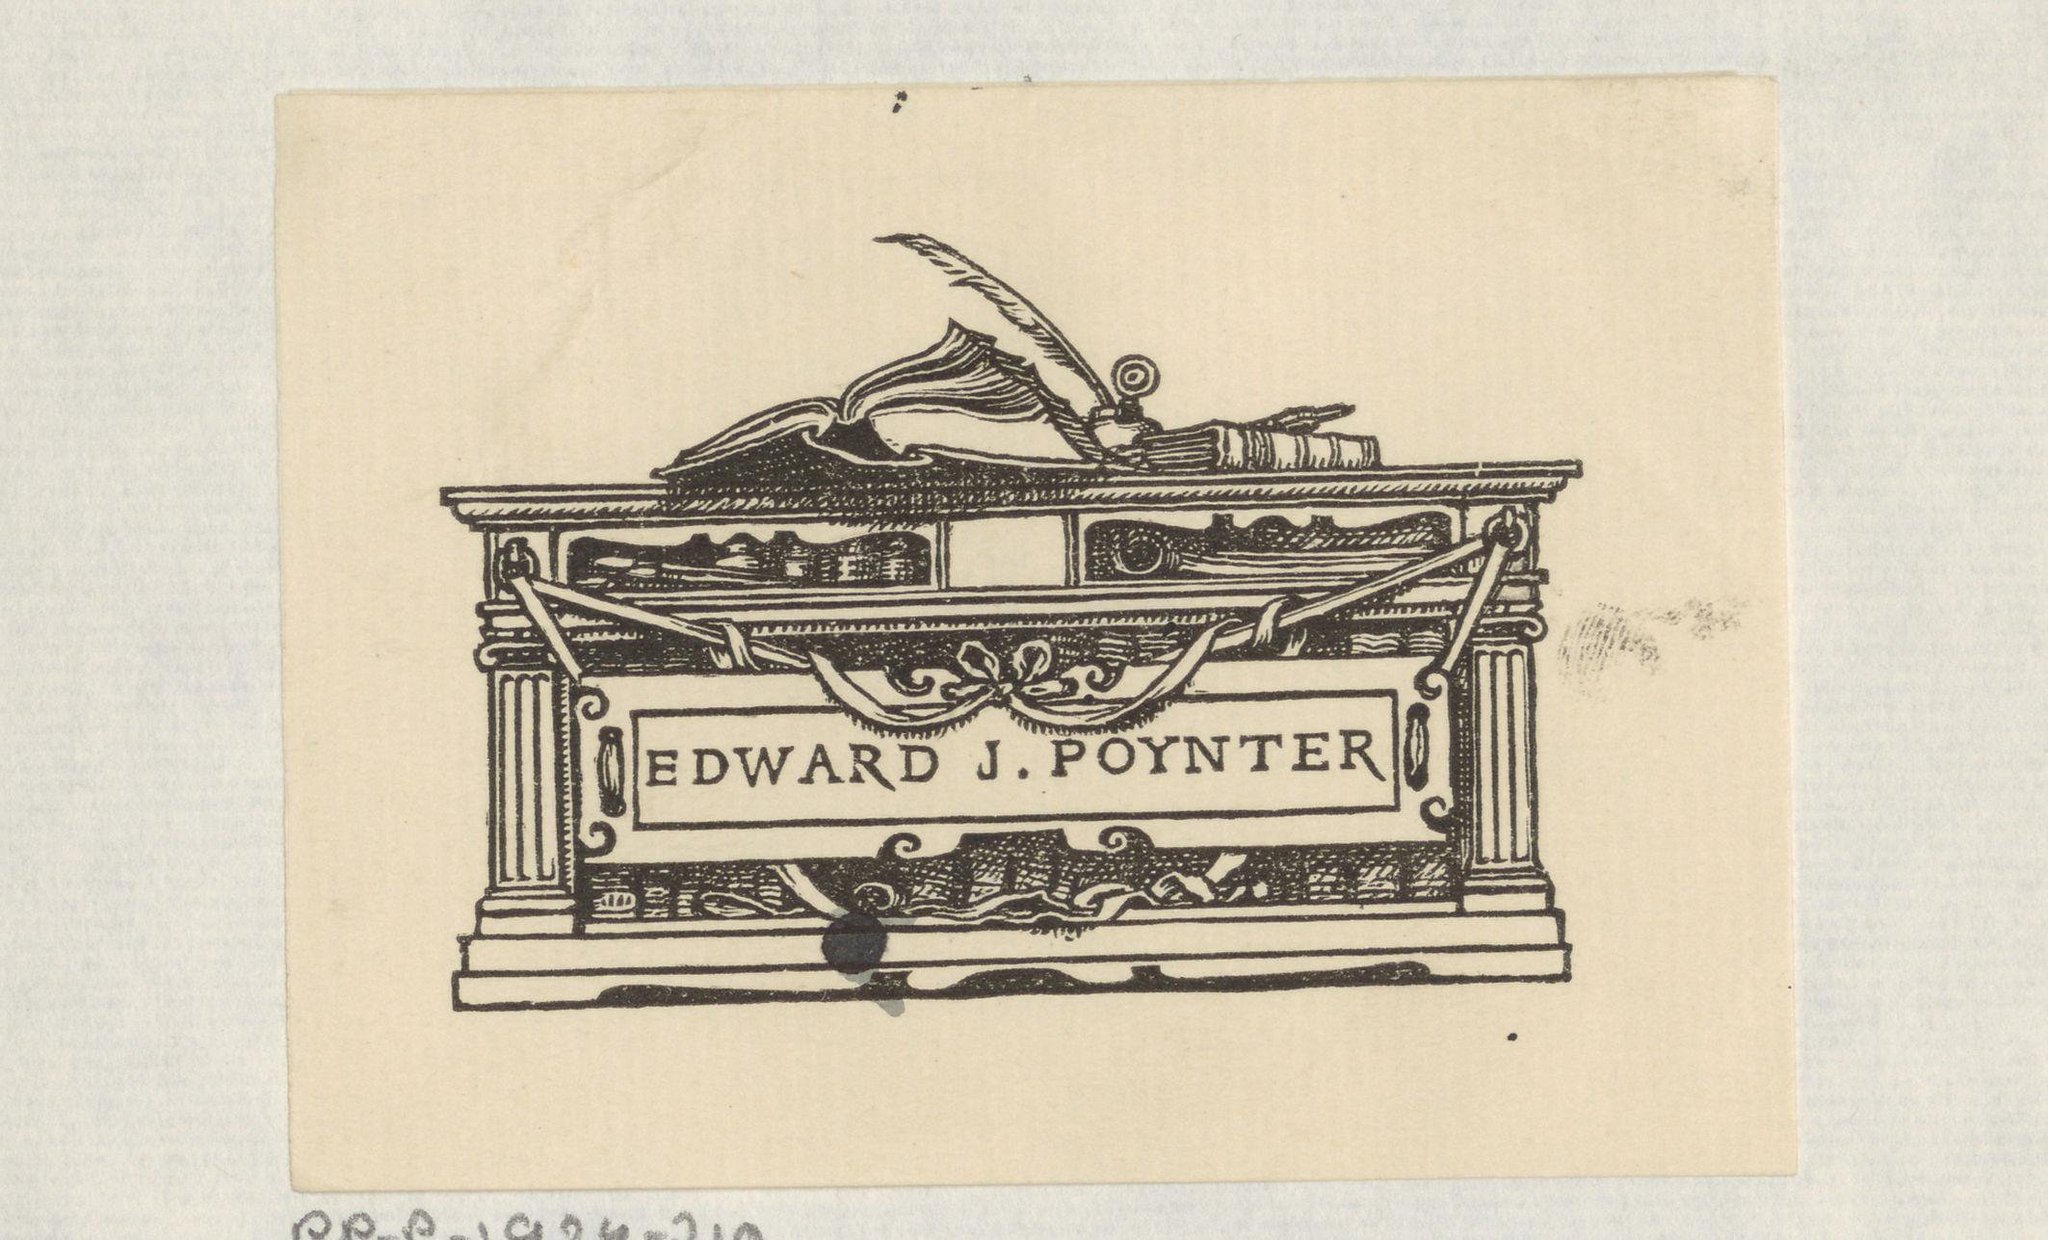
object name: bookplate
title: Edward J. Poynter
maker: Anonymous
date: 1846-1919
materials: paper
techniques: printing block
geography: england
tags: paris, london, draughtsman, edward john poynter (sir), writing-table, writing-desk, book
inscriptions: collector's mark: Lugt 2233